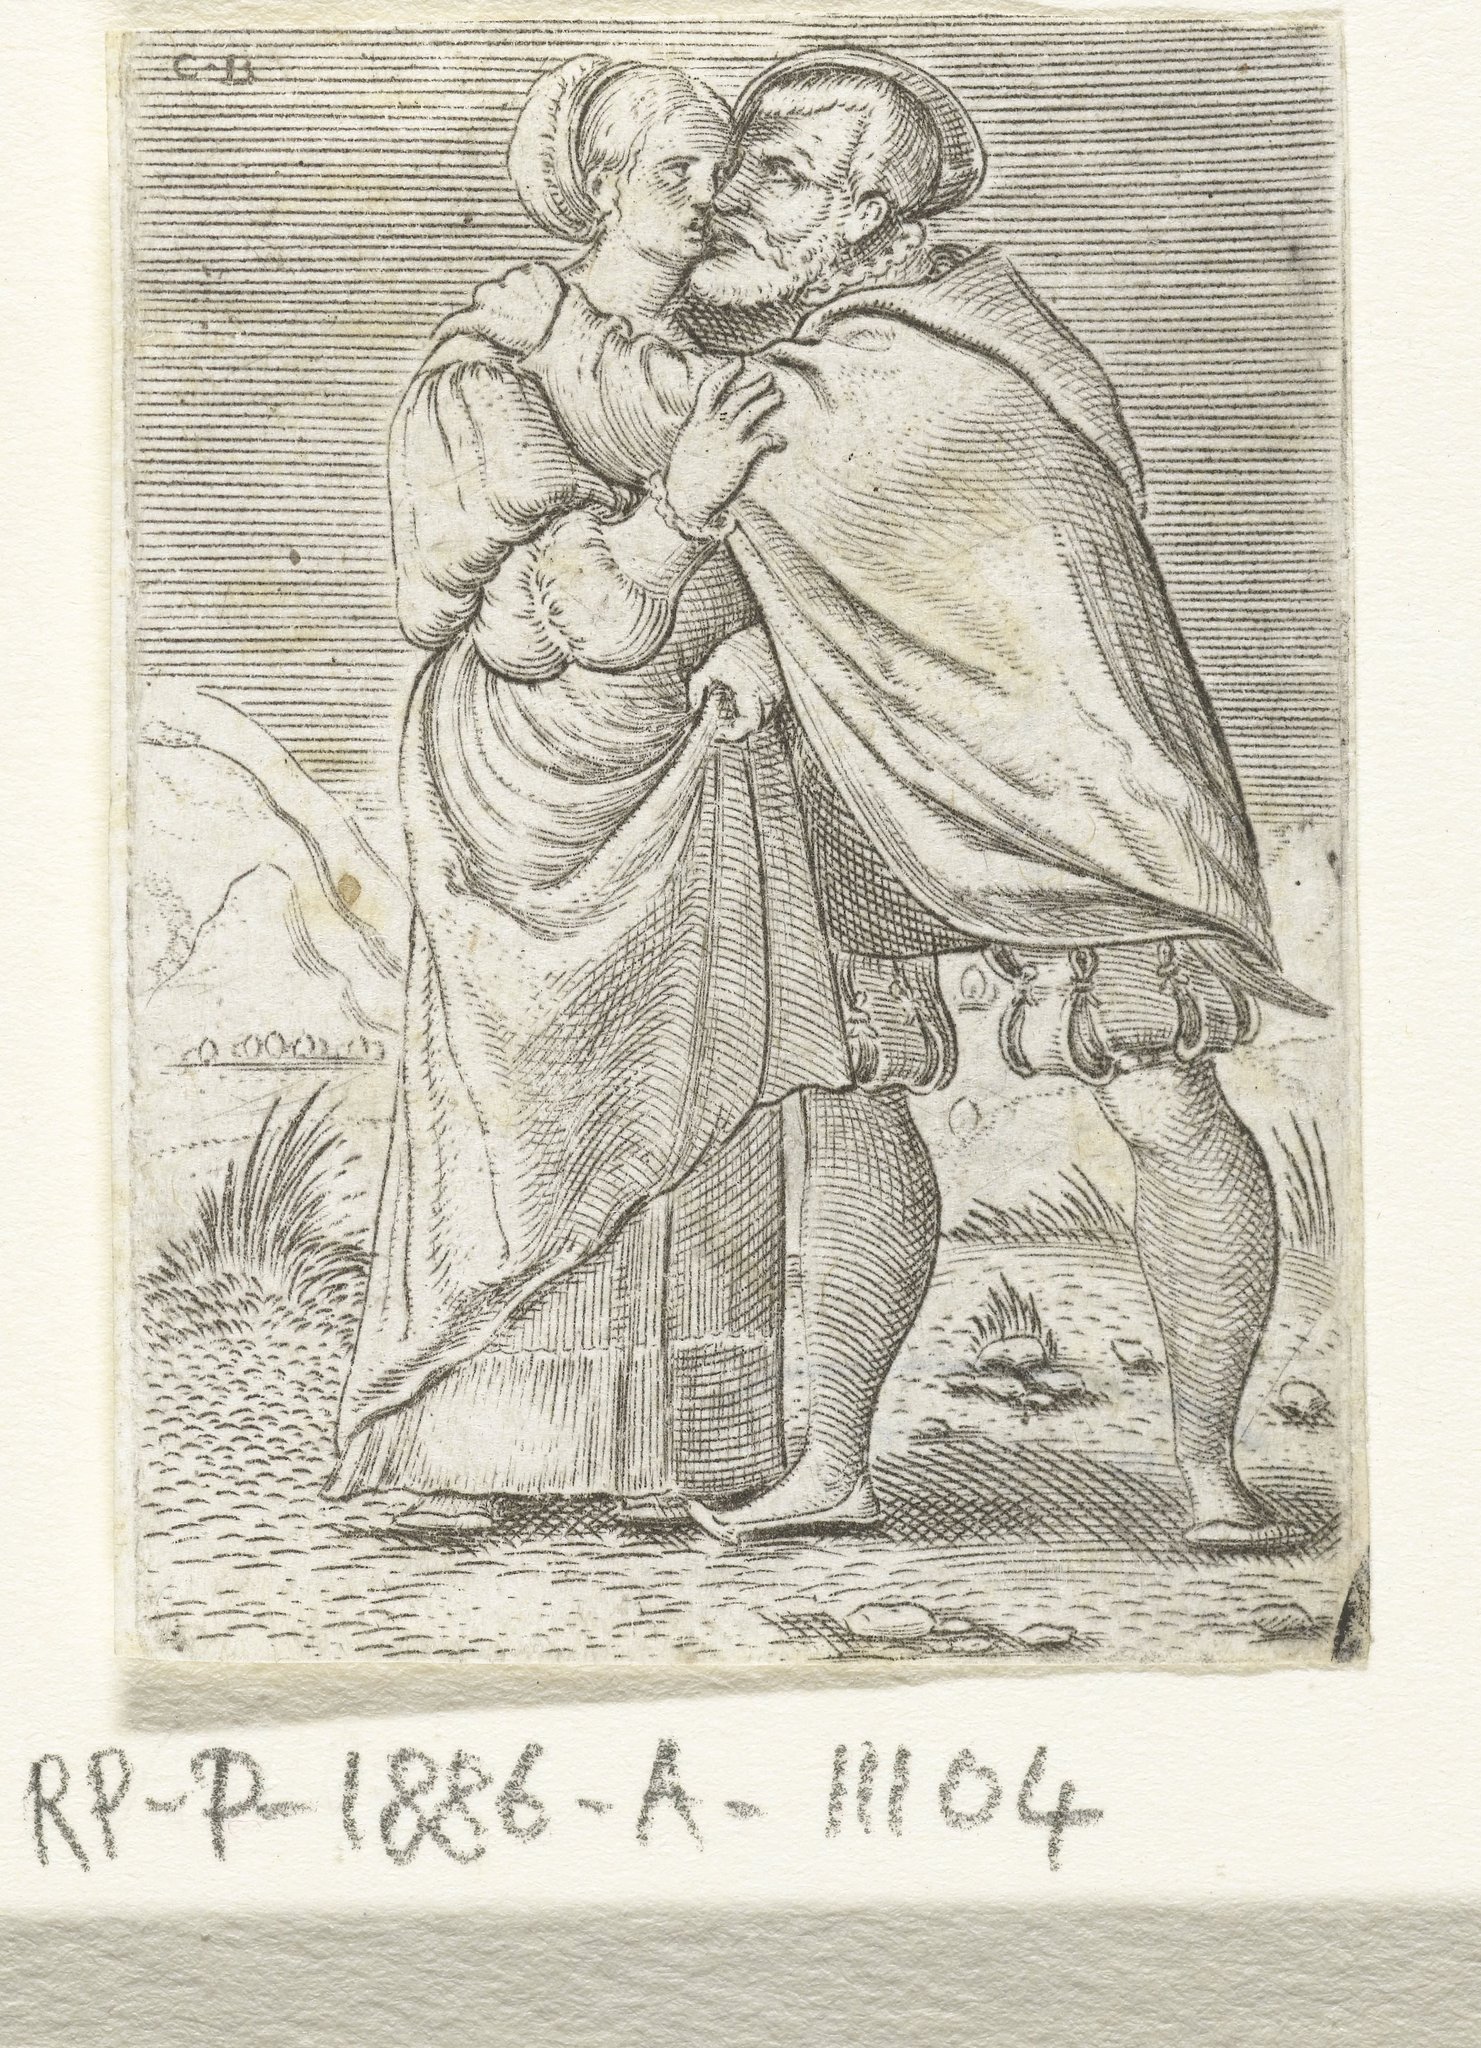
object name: print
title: Dansende stellen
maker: cornelis bos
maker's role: print maker, printer, publisher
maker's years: 1510-1566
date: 1546-1548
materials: paper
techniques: engraving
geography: nuremberg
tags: dancing at wedding feast - dd - out of doors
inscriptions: collector's mark: Lugt 2228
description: Prent uit een serie van 12 prenten met dansende stellen in de buitenlucht.